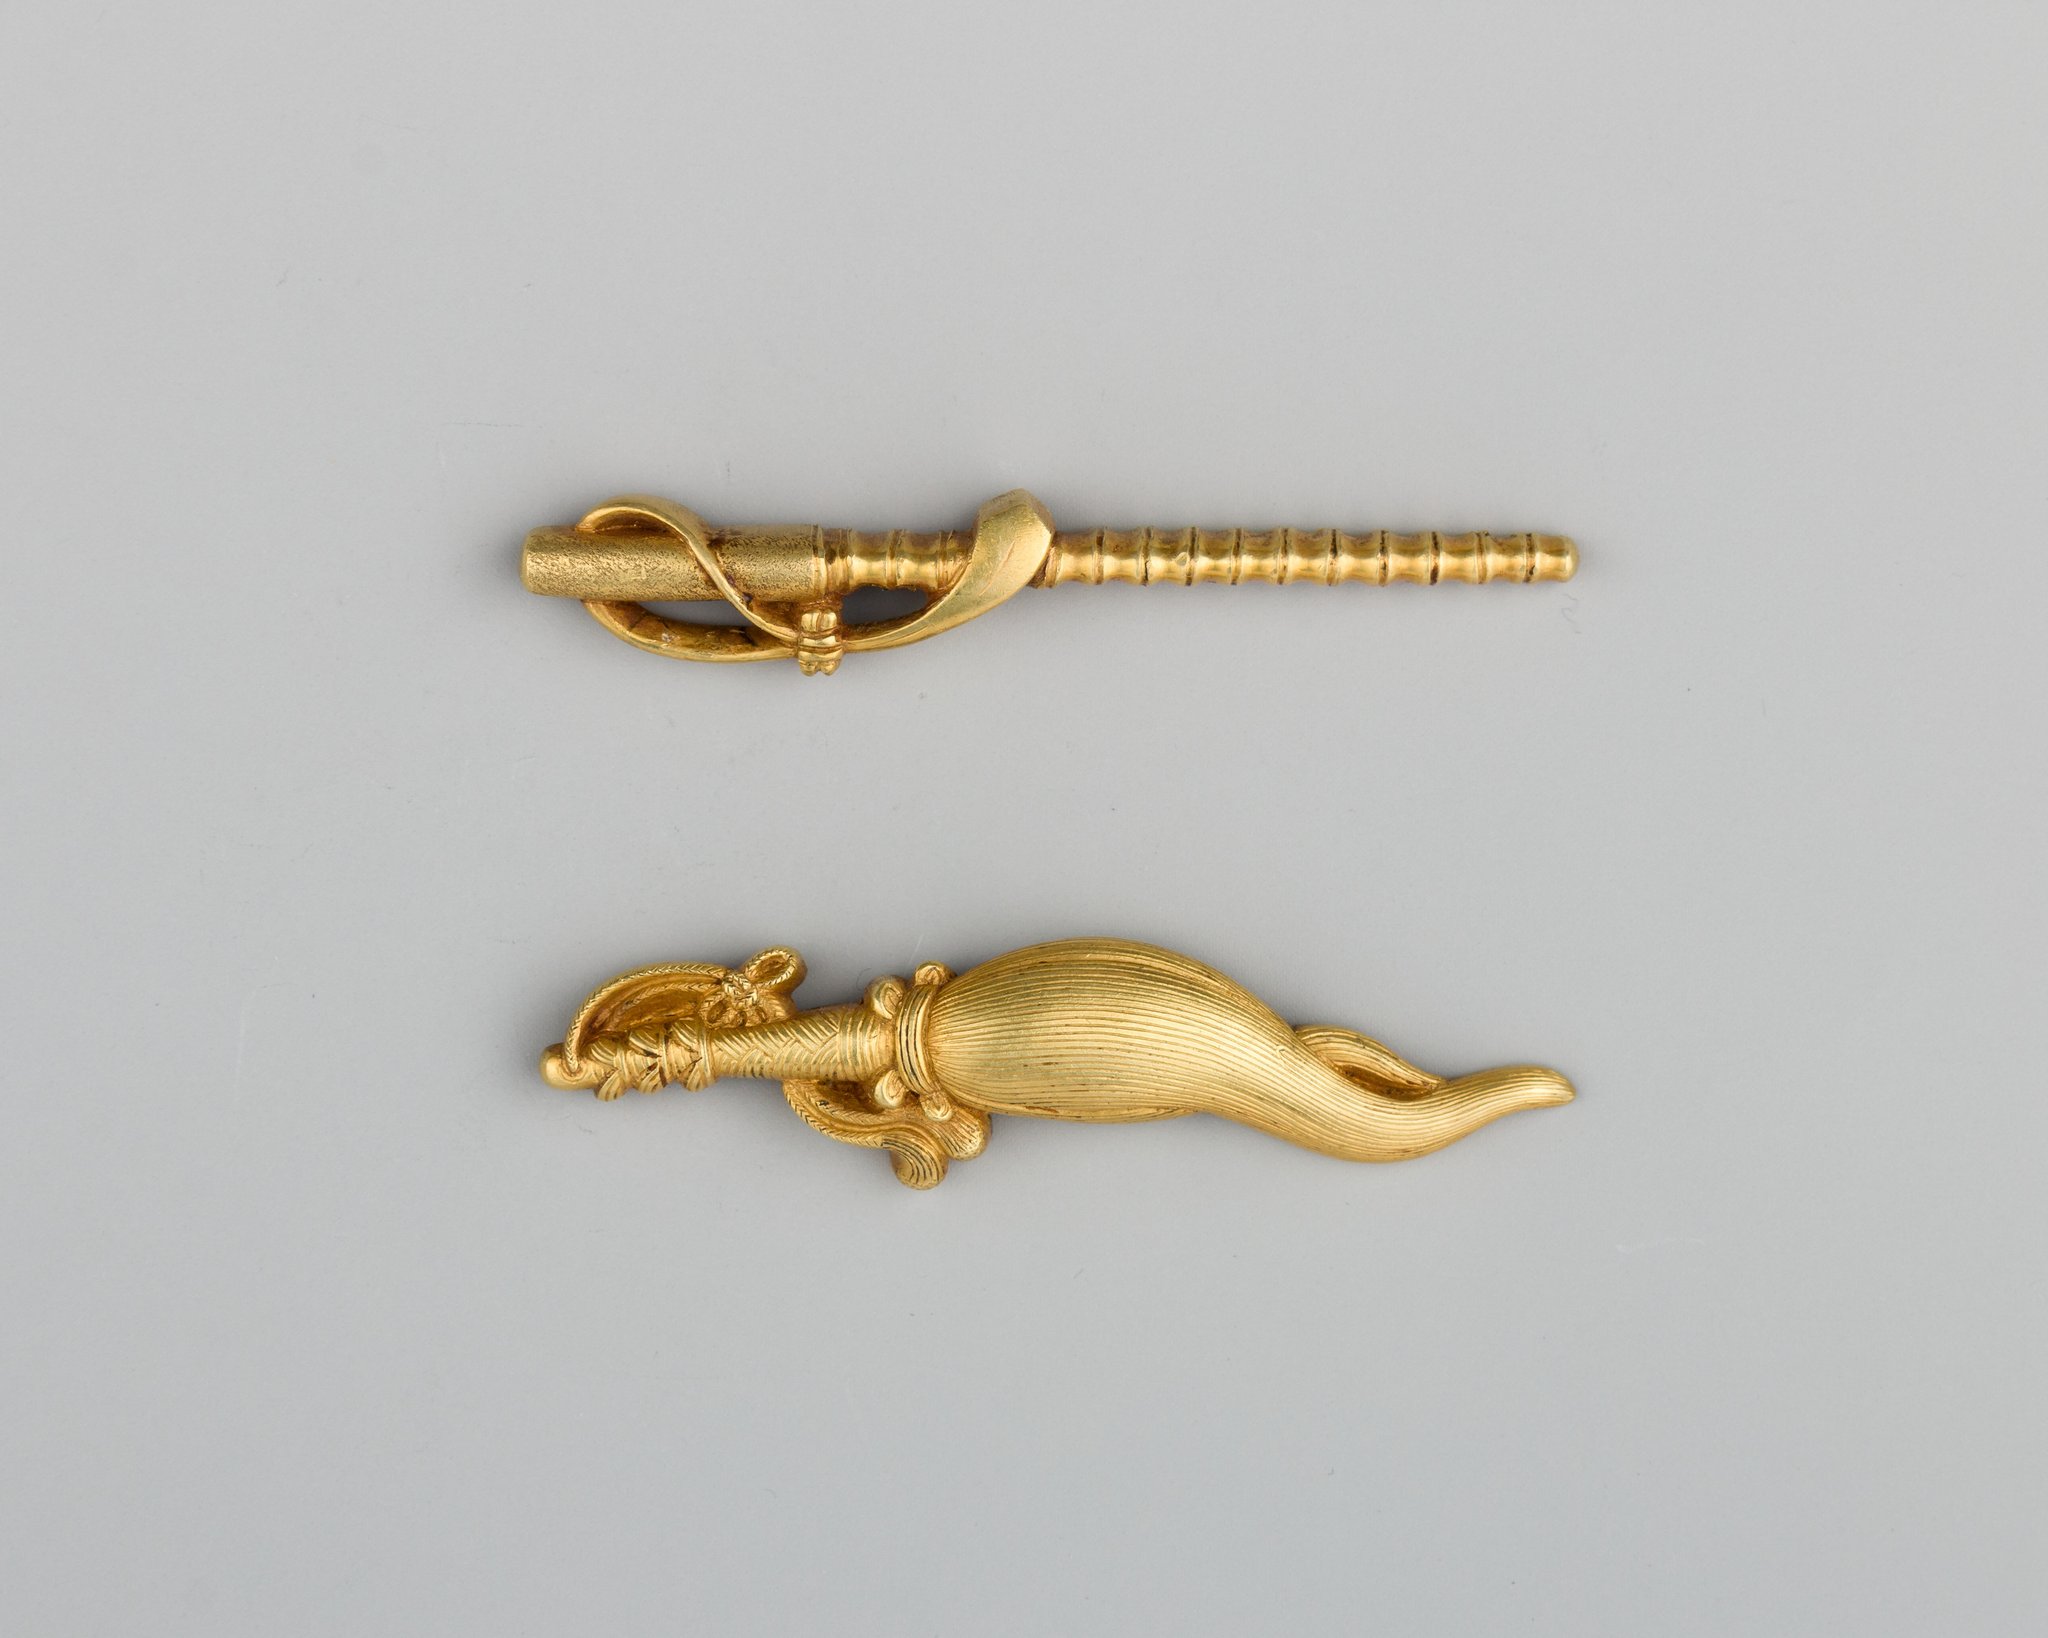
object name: pair of sword grip ornament menuki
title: Pair of Sword-Grip Ornaments (Menuki)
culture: japanese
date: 1701-1800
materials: gold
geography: japan